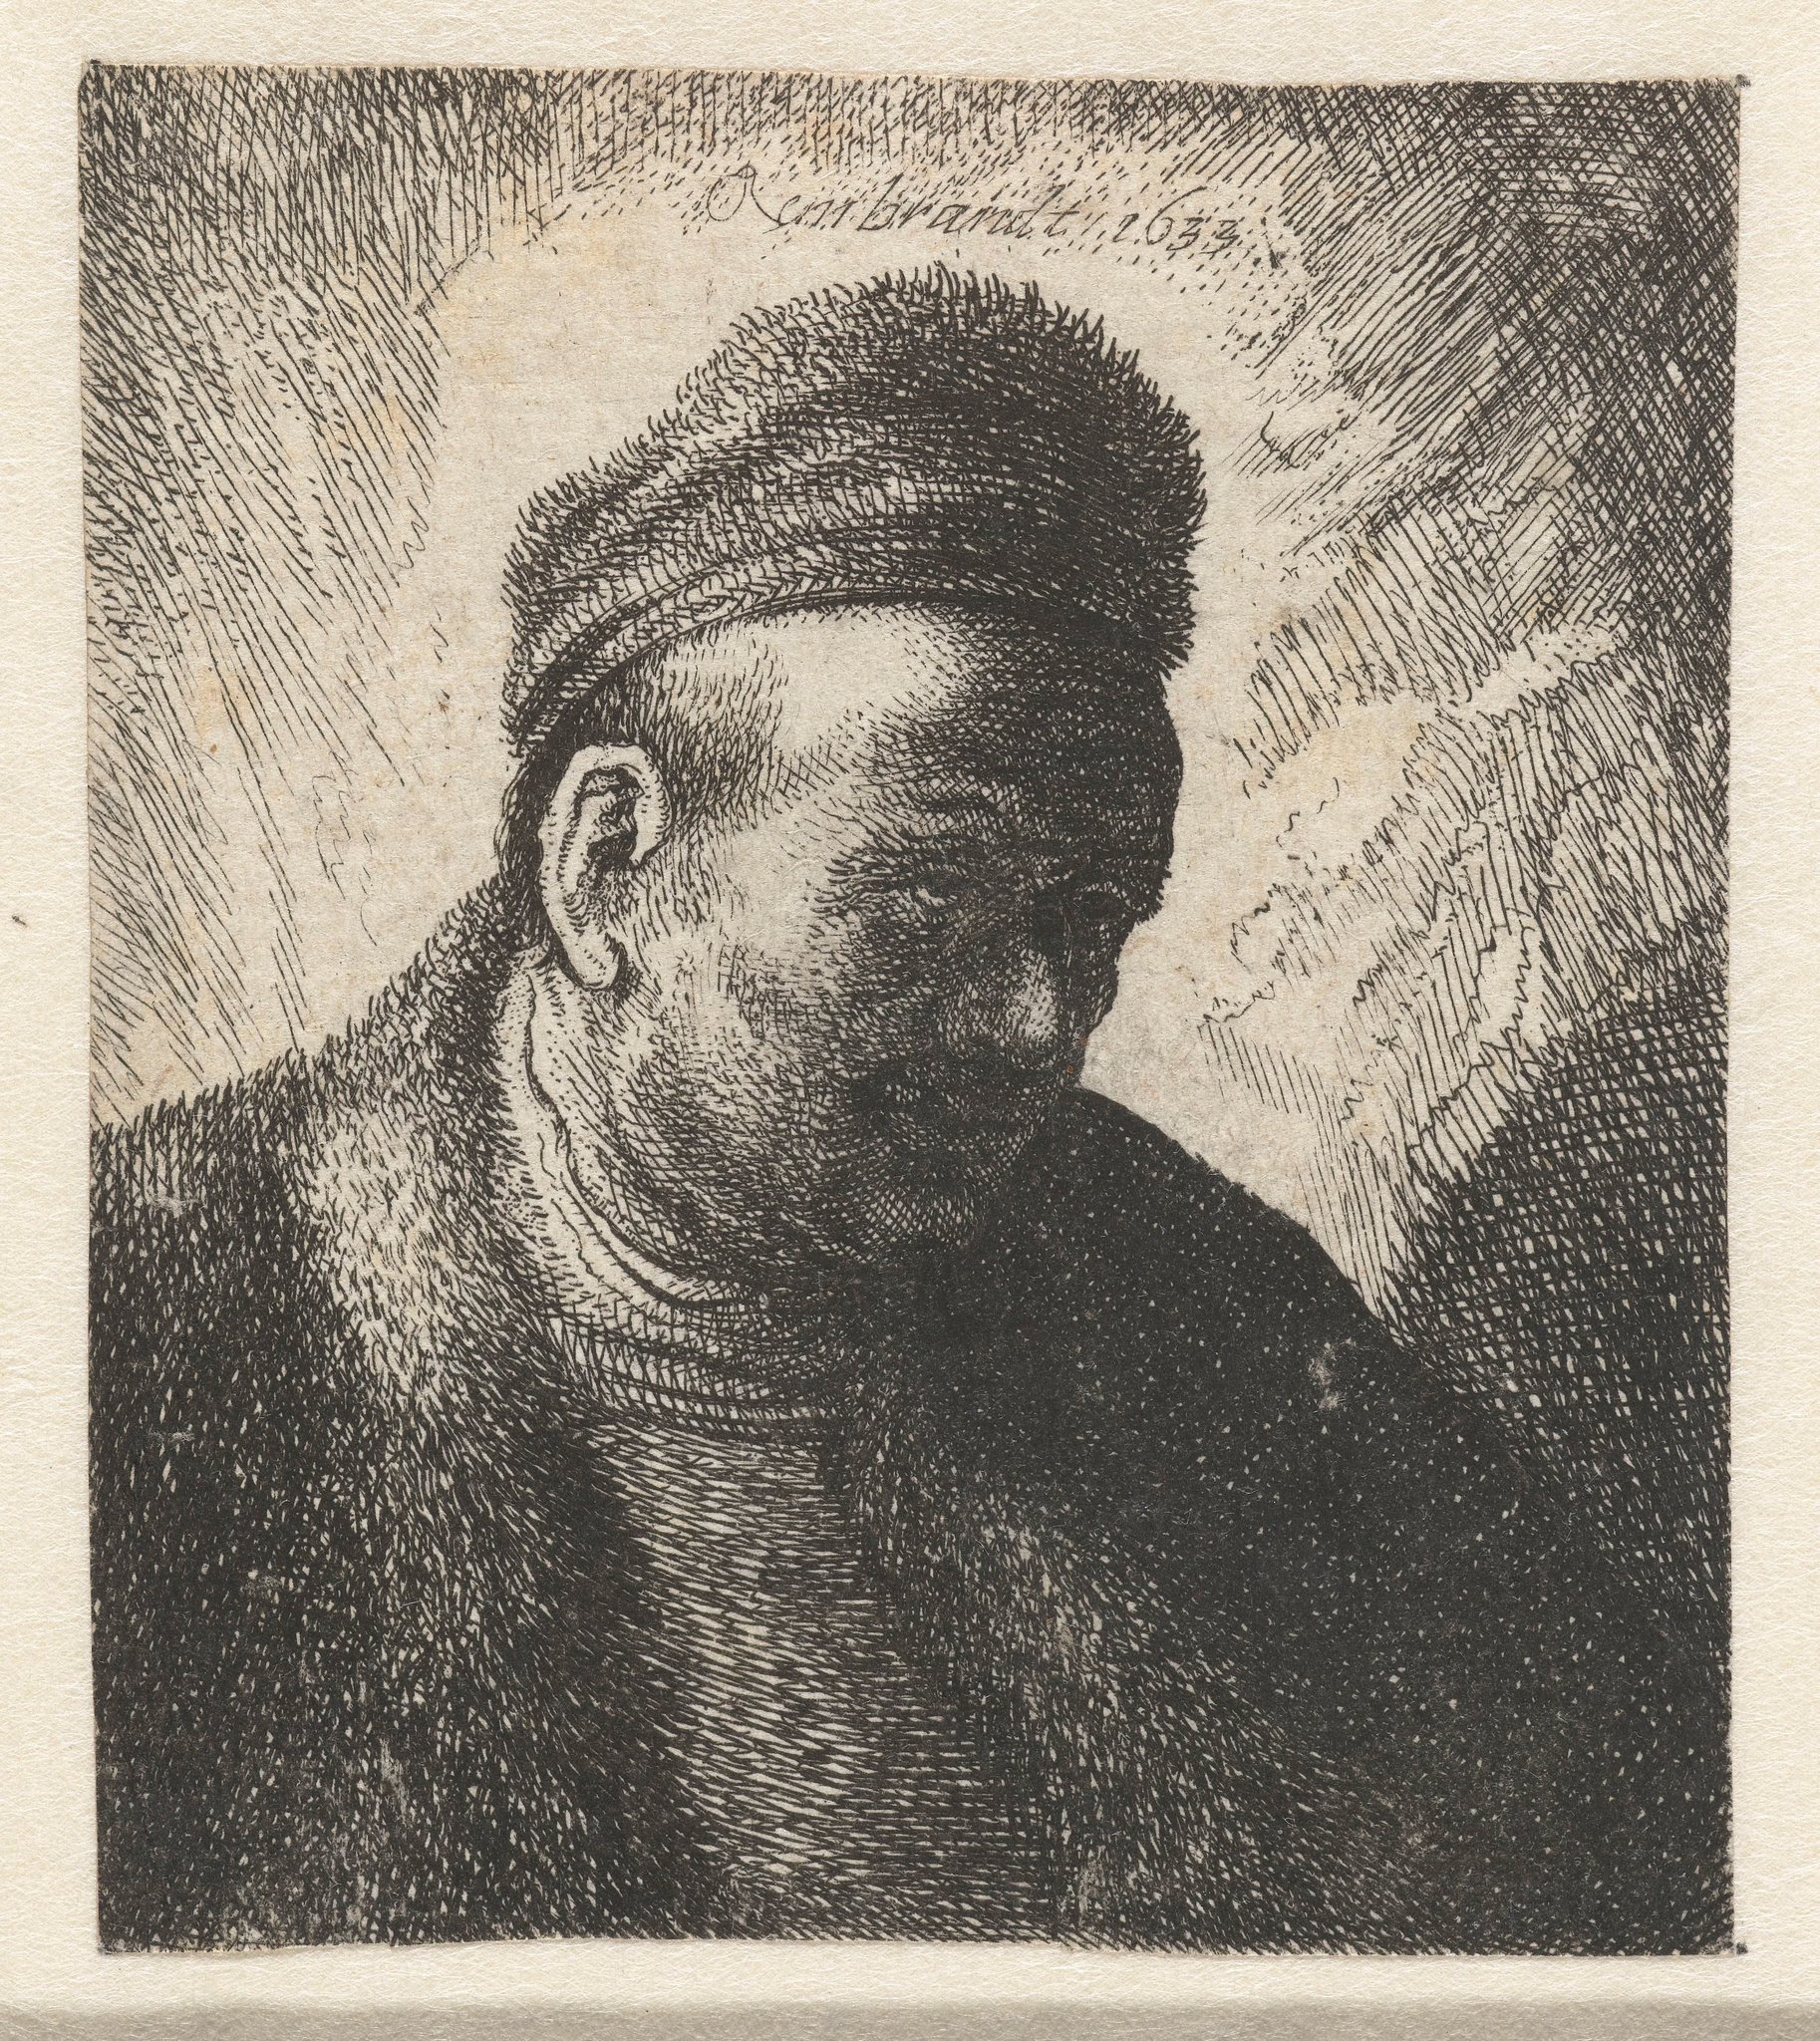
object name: print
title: Beardless man in a fur cloak and cap: bust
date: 1633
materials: paper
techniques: etching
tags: head-gear (with name), adult man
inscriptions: collector's mark: Lugt 2760, collector's mark: Lugt 548, collector's mark: Lugt 2228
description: Spiegelbeeldige kopie naar de gelijknamige prent van Rembrandt.